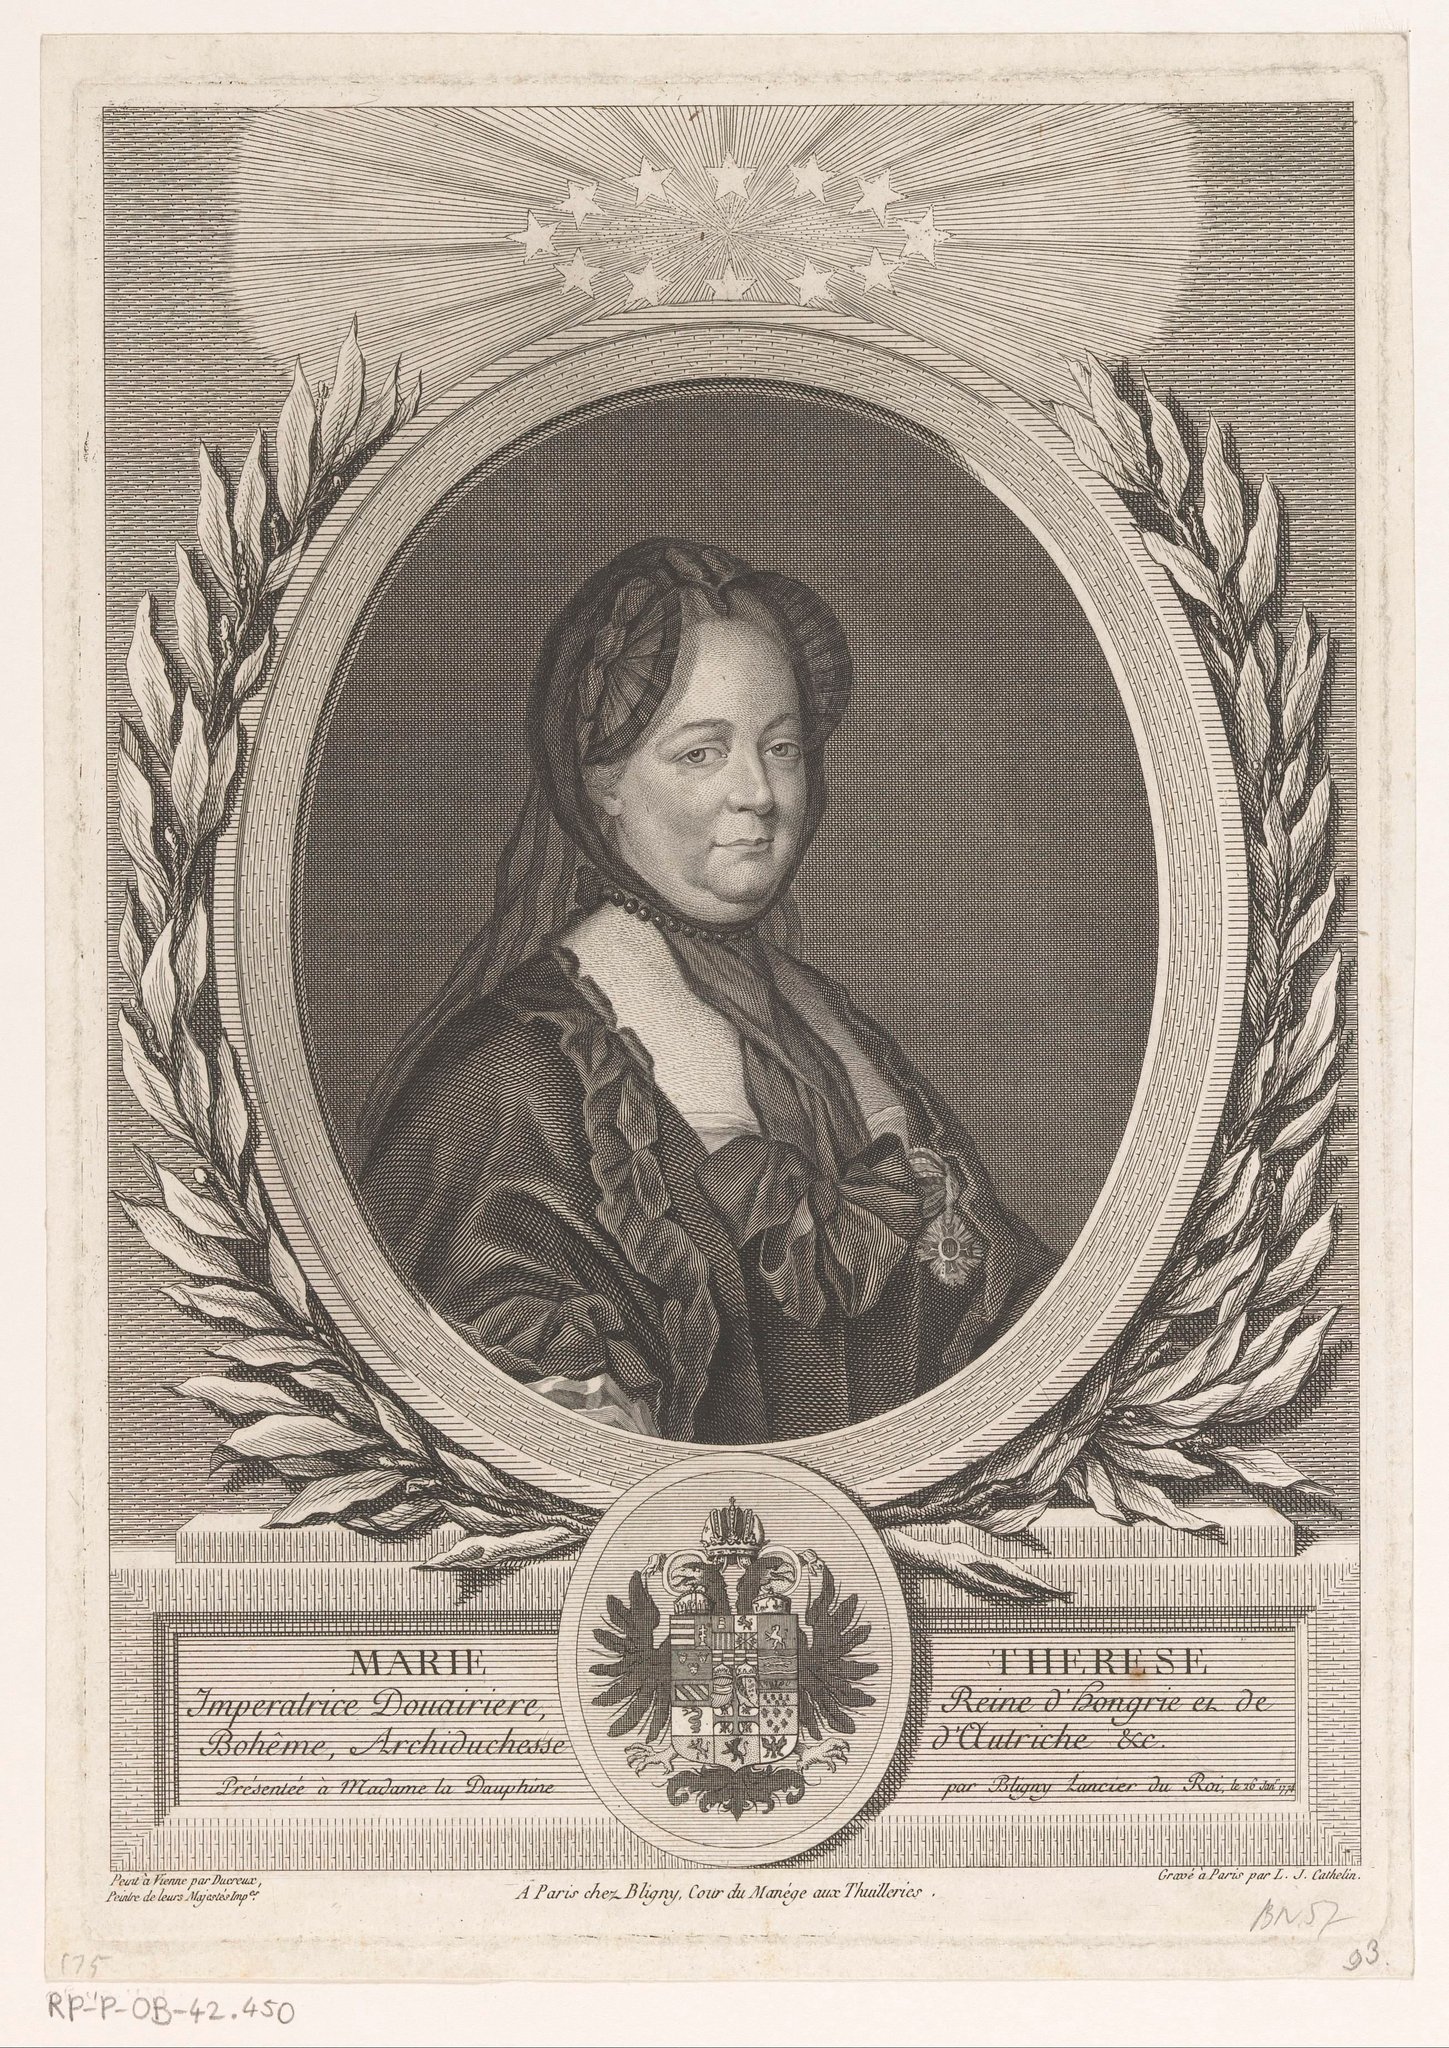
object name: print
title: Portret van keizerin Maria Theresia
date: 1774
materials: paper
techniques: engraving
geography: france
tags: vienna, maria theresia (rooms-duits keizerin), head-gear, queen, empress, etc. (wife of a ruler), historical persons, dress, gown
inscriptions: collector's mark: Lugt 2228